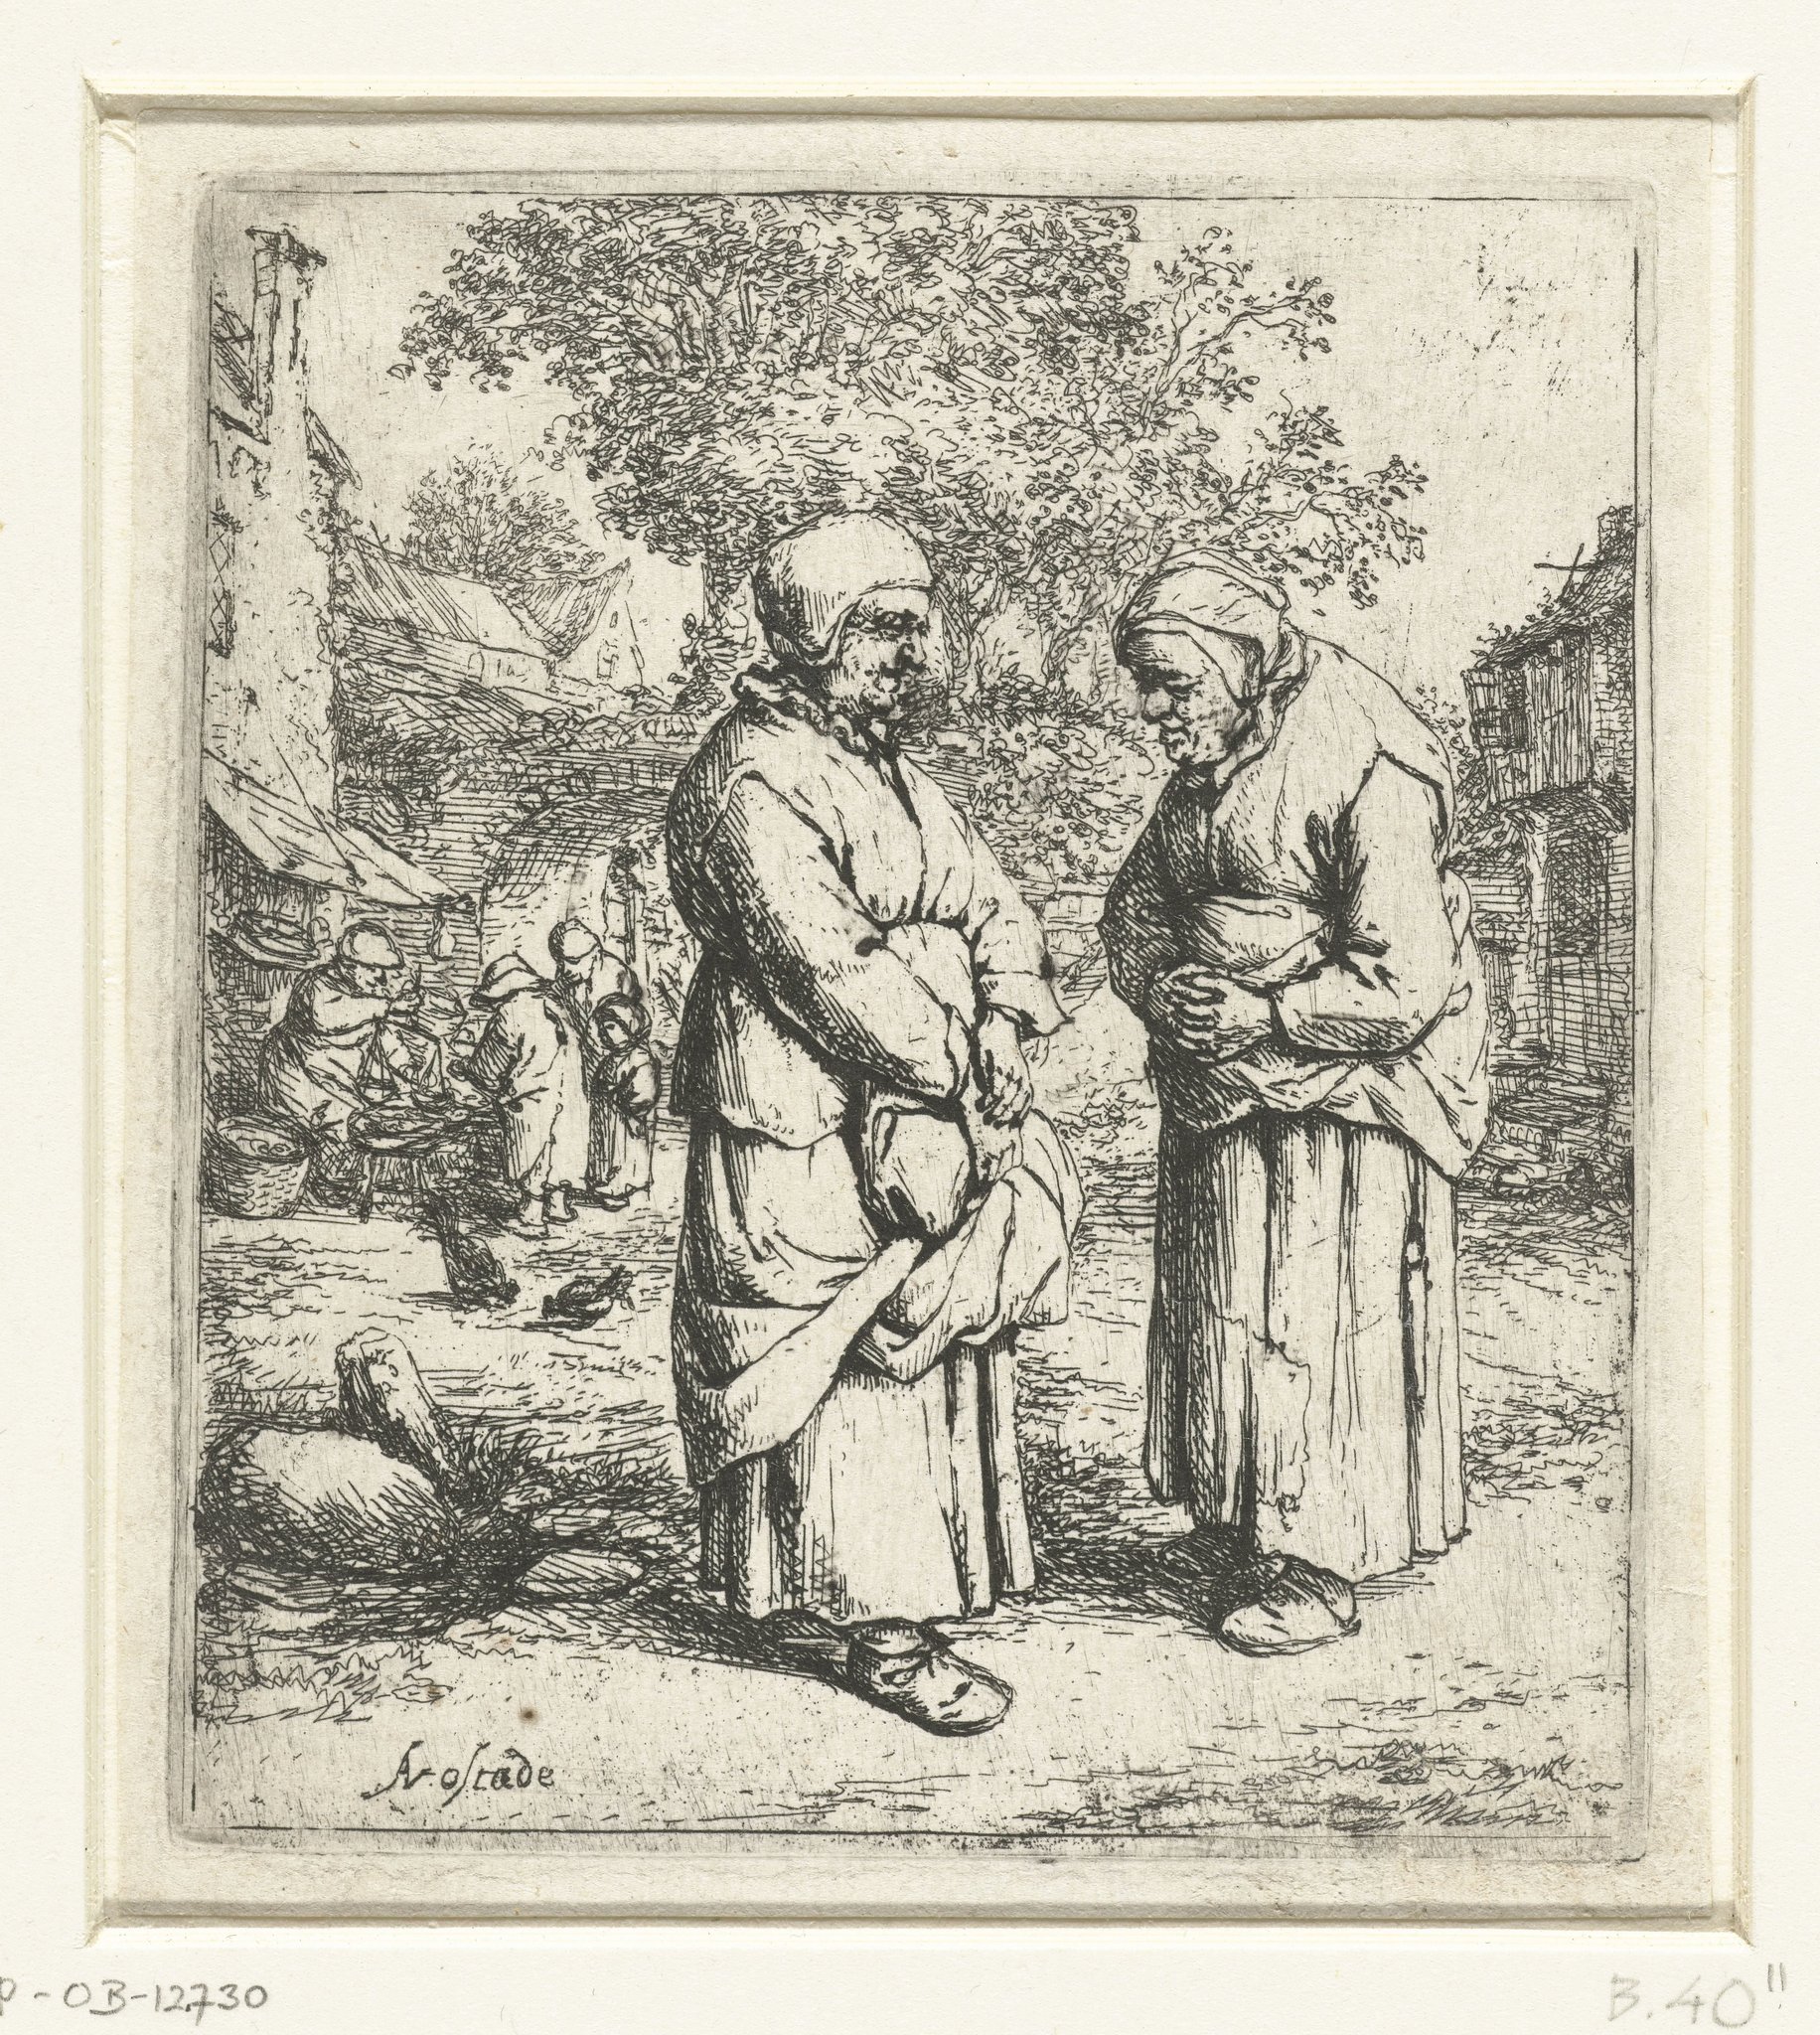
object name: print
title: De twee huisvrouwen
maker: adriaen van ostade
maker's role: draughtsman, painter, print maker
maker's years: 1610-1685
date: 1648-1654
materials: paper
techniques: etching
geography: haarlem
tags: old woman, conversation, dialogue; conversation piece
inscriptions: collector's mark: Lugt 240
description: In een dorpsstraat zijn twee oude vrouwen met elkaar in gesprek, enkele figuren staan bij een winkeltje op de achtergrond